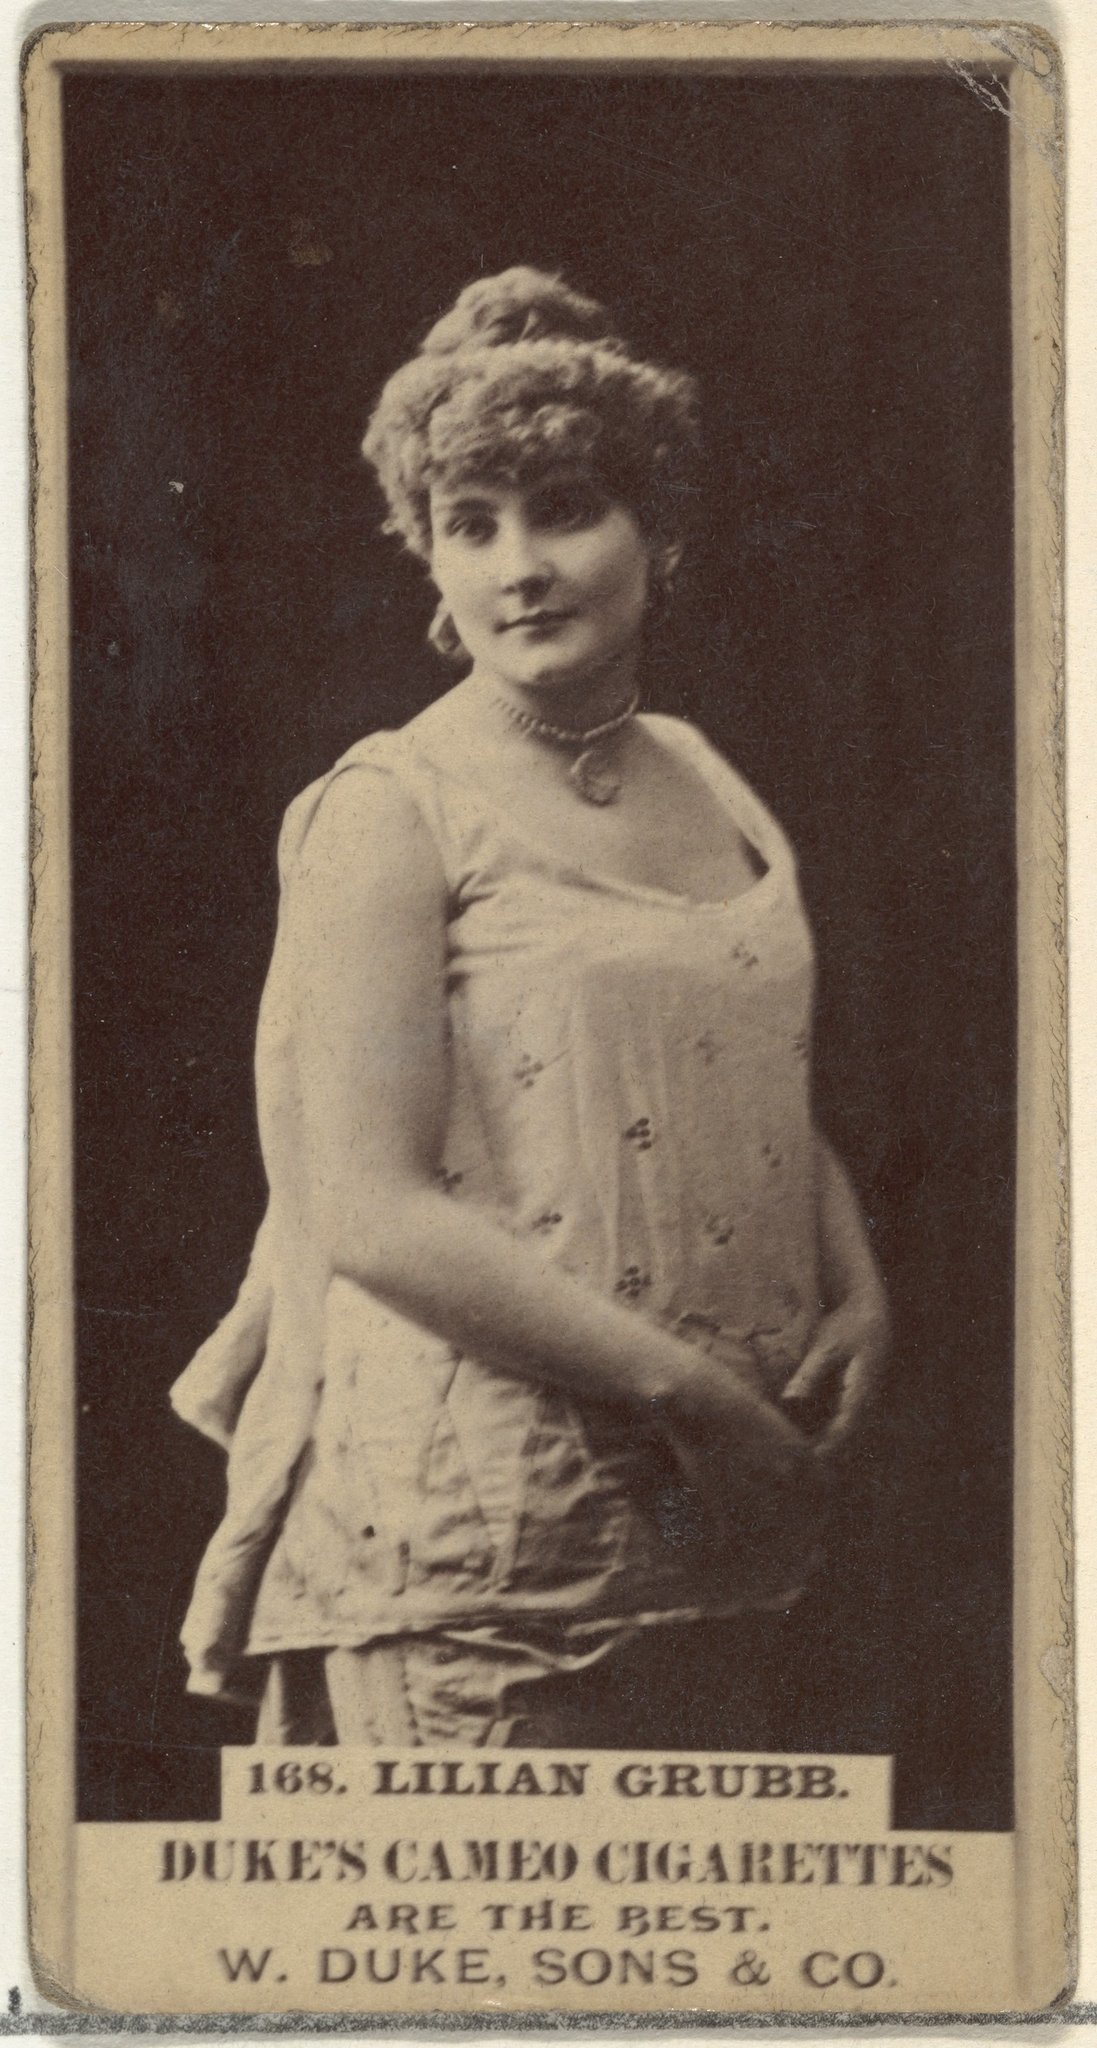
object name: photograph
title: Card Number 168, Lilian Grubb, from the Actors and Actresses series (N145-5) issued by Duke Sons & Co. to promote Cameo Cigarettes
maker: w. duke, sons & co.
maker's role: publisher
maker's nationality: american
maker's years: 1870-1920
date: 1880-1889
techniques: albumen silver print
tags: portraits,women,actresses